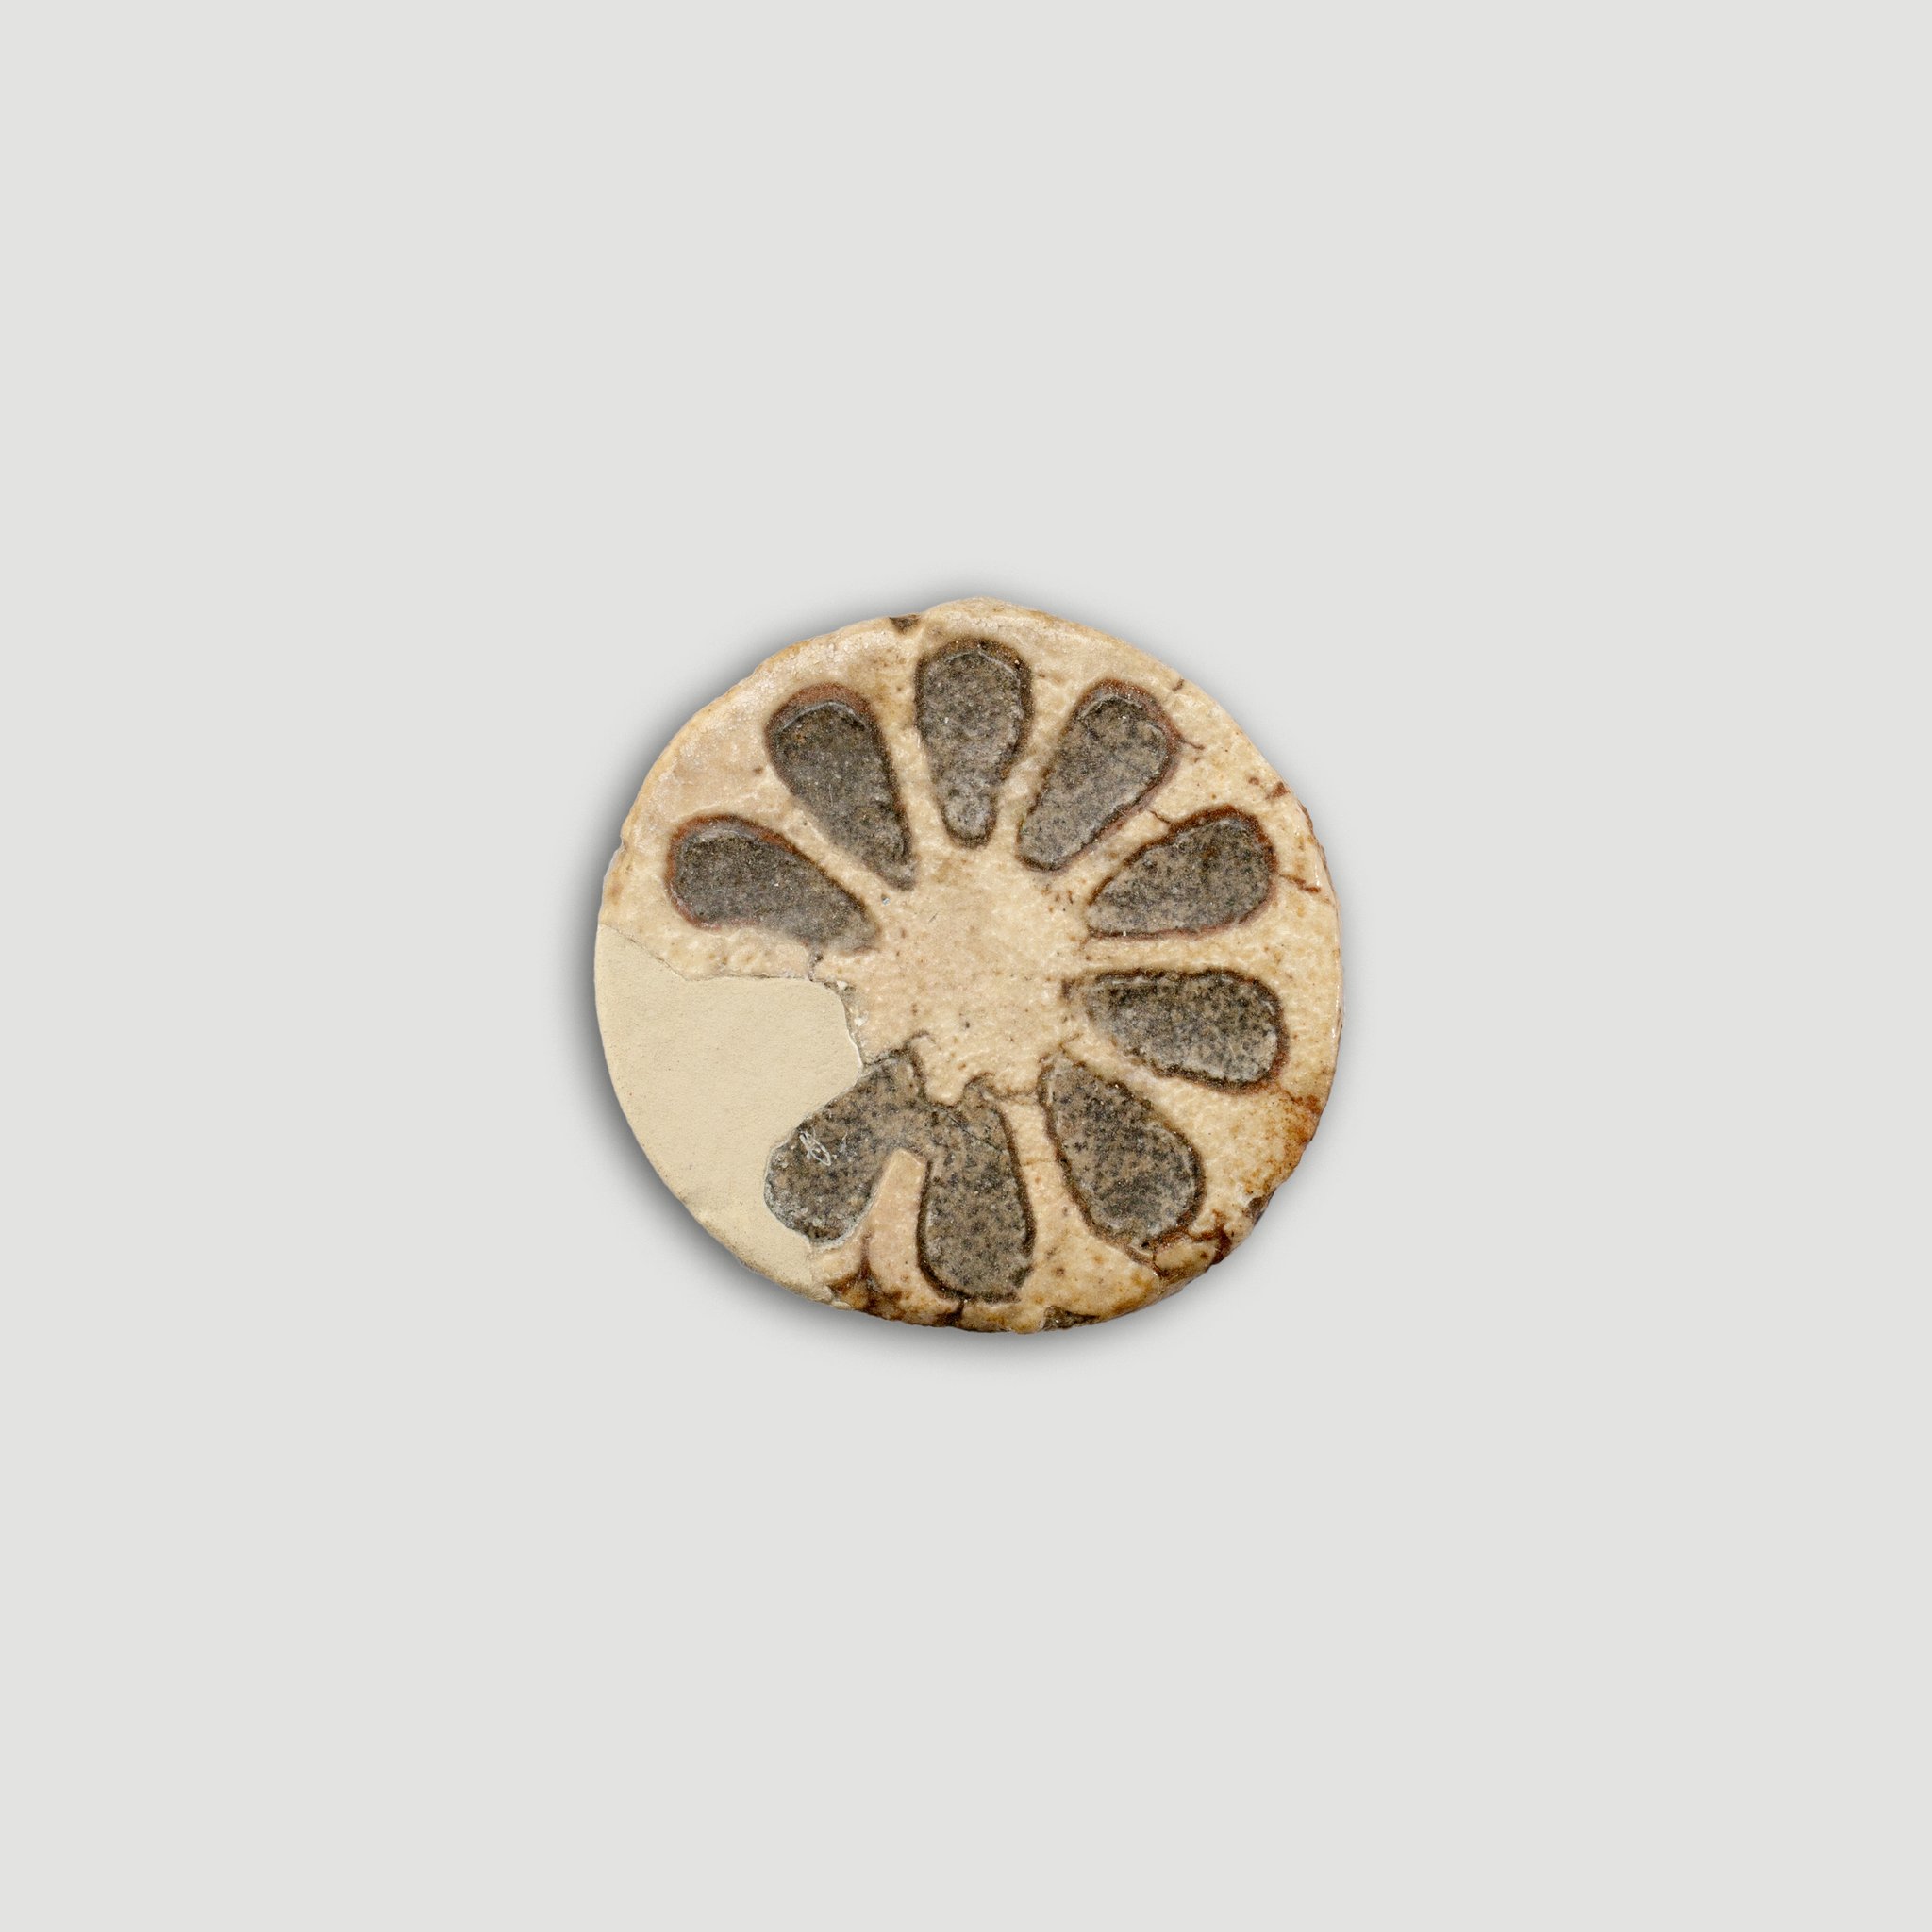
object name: tile, palace of ramesses ii, rosette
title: Tiles and ornaments from the palace of Ramesses II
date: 1279-1213 BCE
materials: faience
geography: egypt